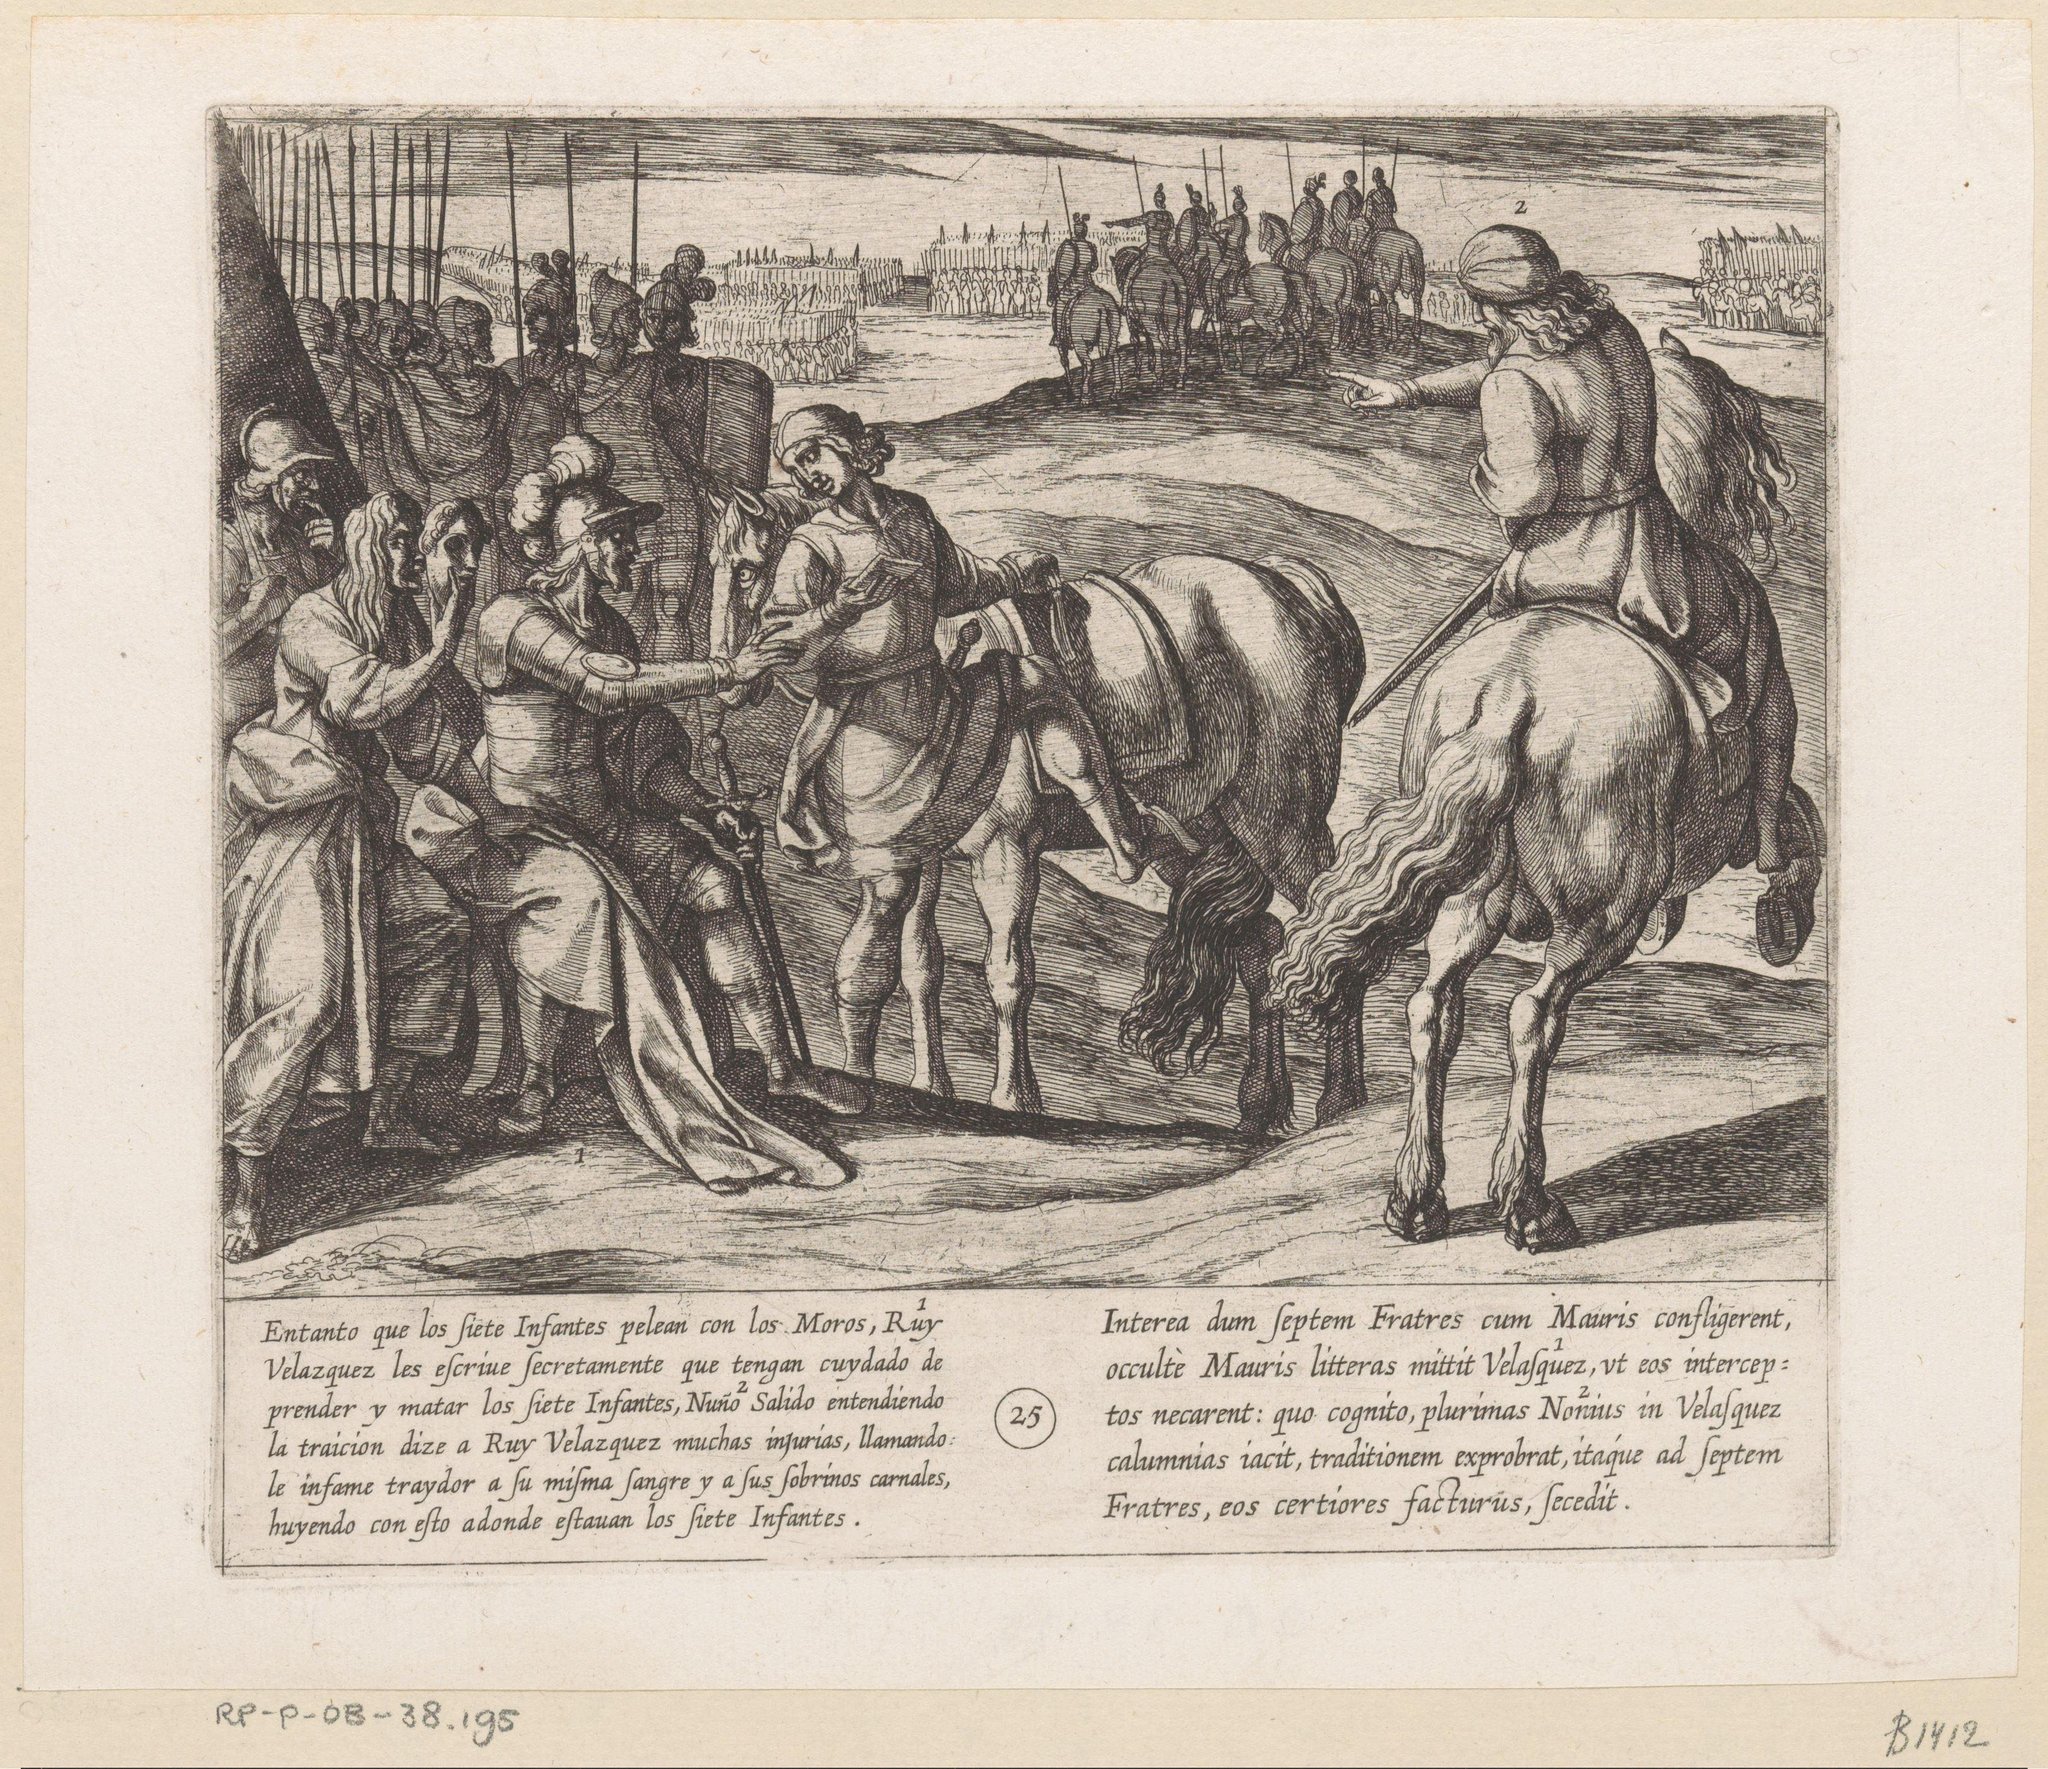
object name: print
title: Historia Septem Infantium de Lara/ Historia de los Siete Infantes de Lara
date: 1612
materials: paper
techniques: etching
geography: antwerp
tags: warfare; military affairs (+ cavalry, horsemen), tales and fairy tales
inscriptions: collector's mark: Lugt 240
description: Deze prent maakt deel uit van een reeks van 40 prenten (+ titelprent) met voorstellingen uit het volksverhaal over de zeven infanten van Lara.